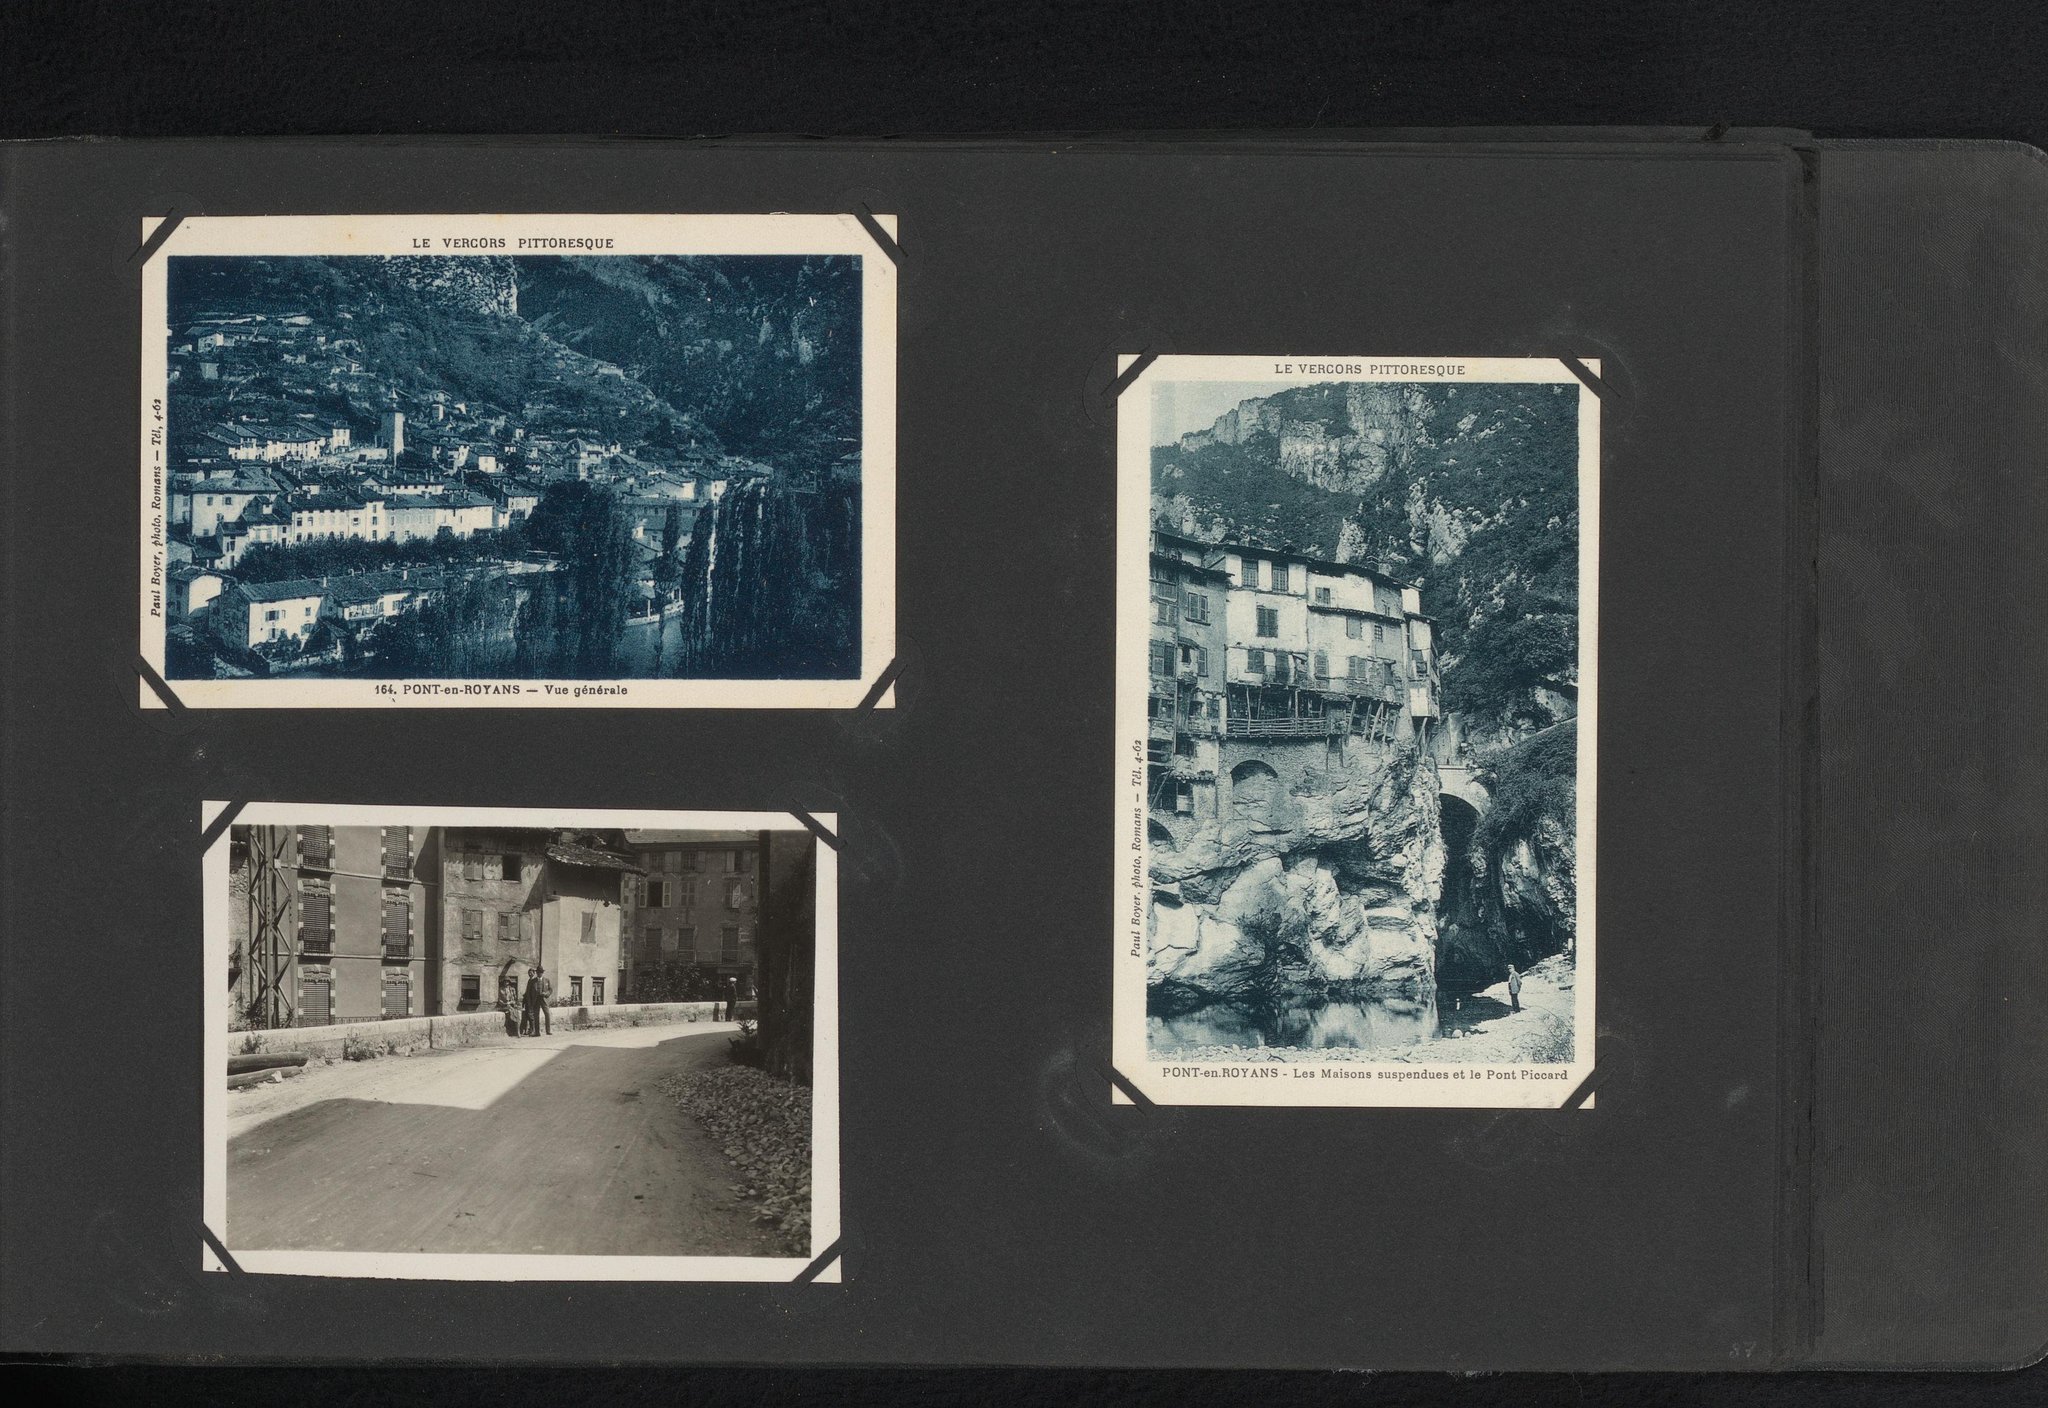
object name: photograph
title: Twee fotomechanische prentbriefkaarten en een foto van Pont-en-Royans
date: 1908-1929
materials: paper, cardboard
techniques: photograph, gelatin silver print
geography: pont-en-royans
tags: the hague, caroline louise van den berg-van den berg, carel frederik van den berg (cay), amsterdam, frank willem van den berg (1912-1998), village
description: Deze prenten en foto maken deel uit van een album.